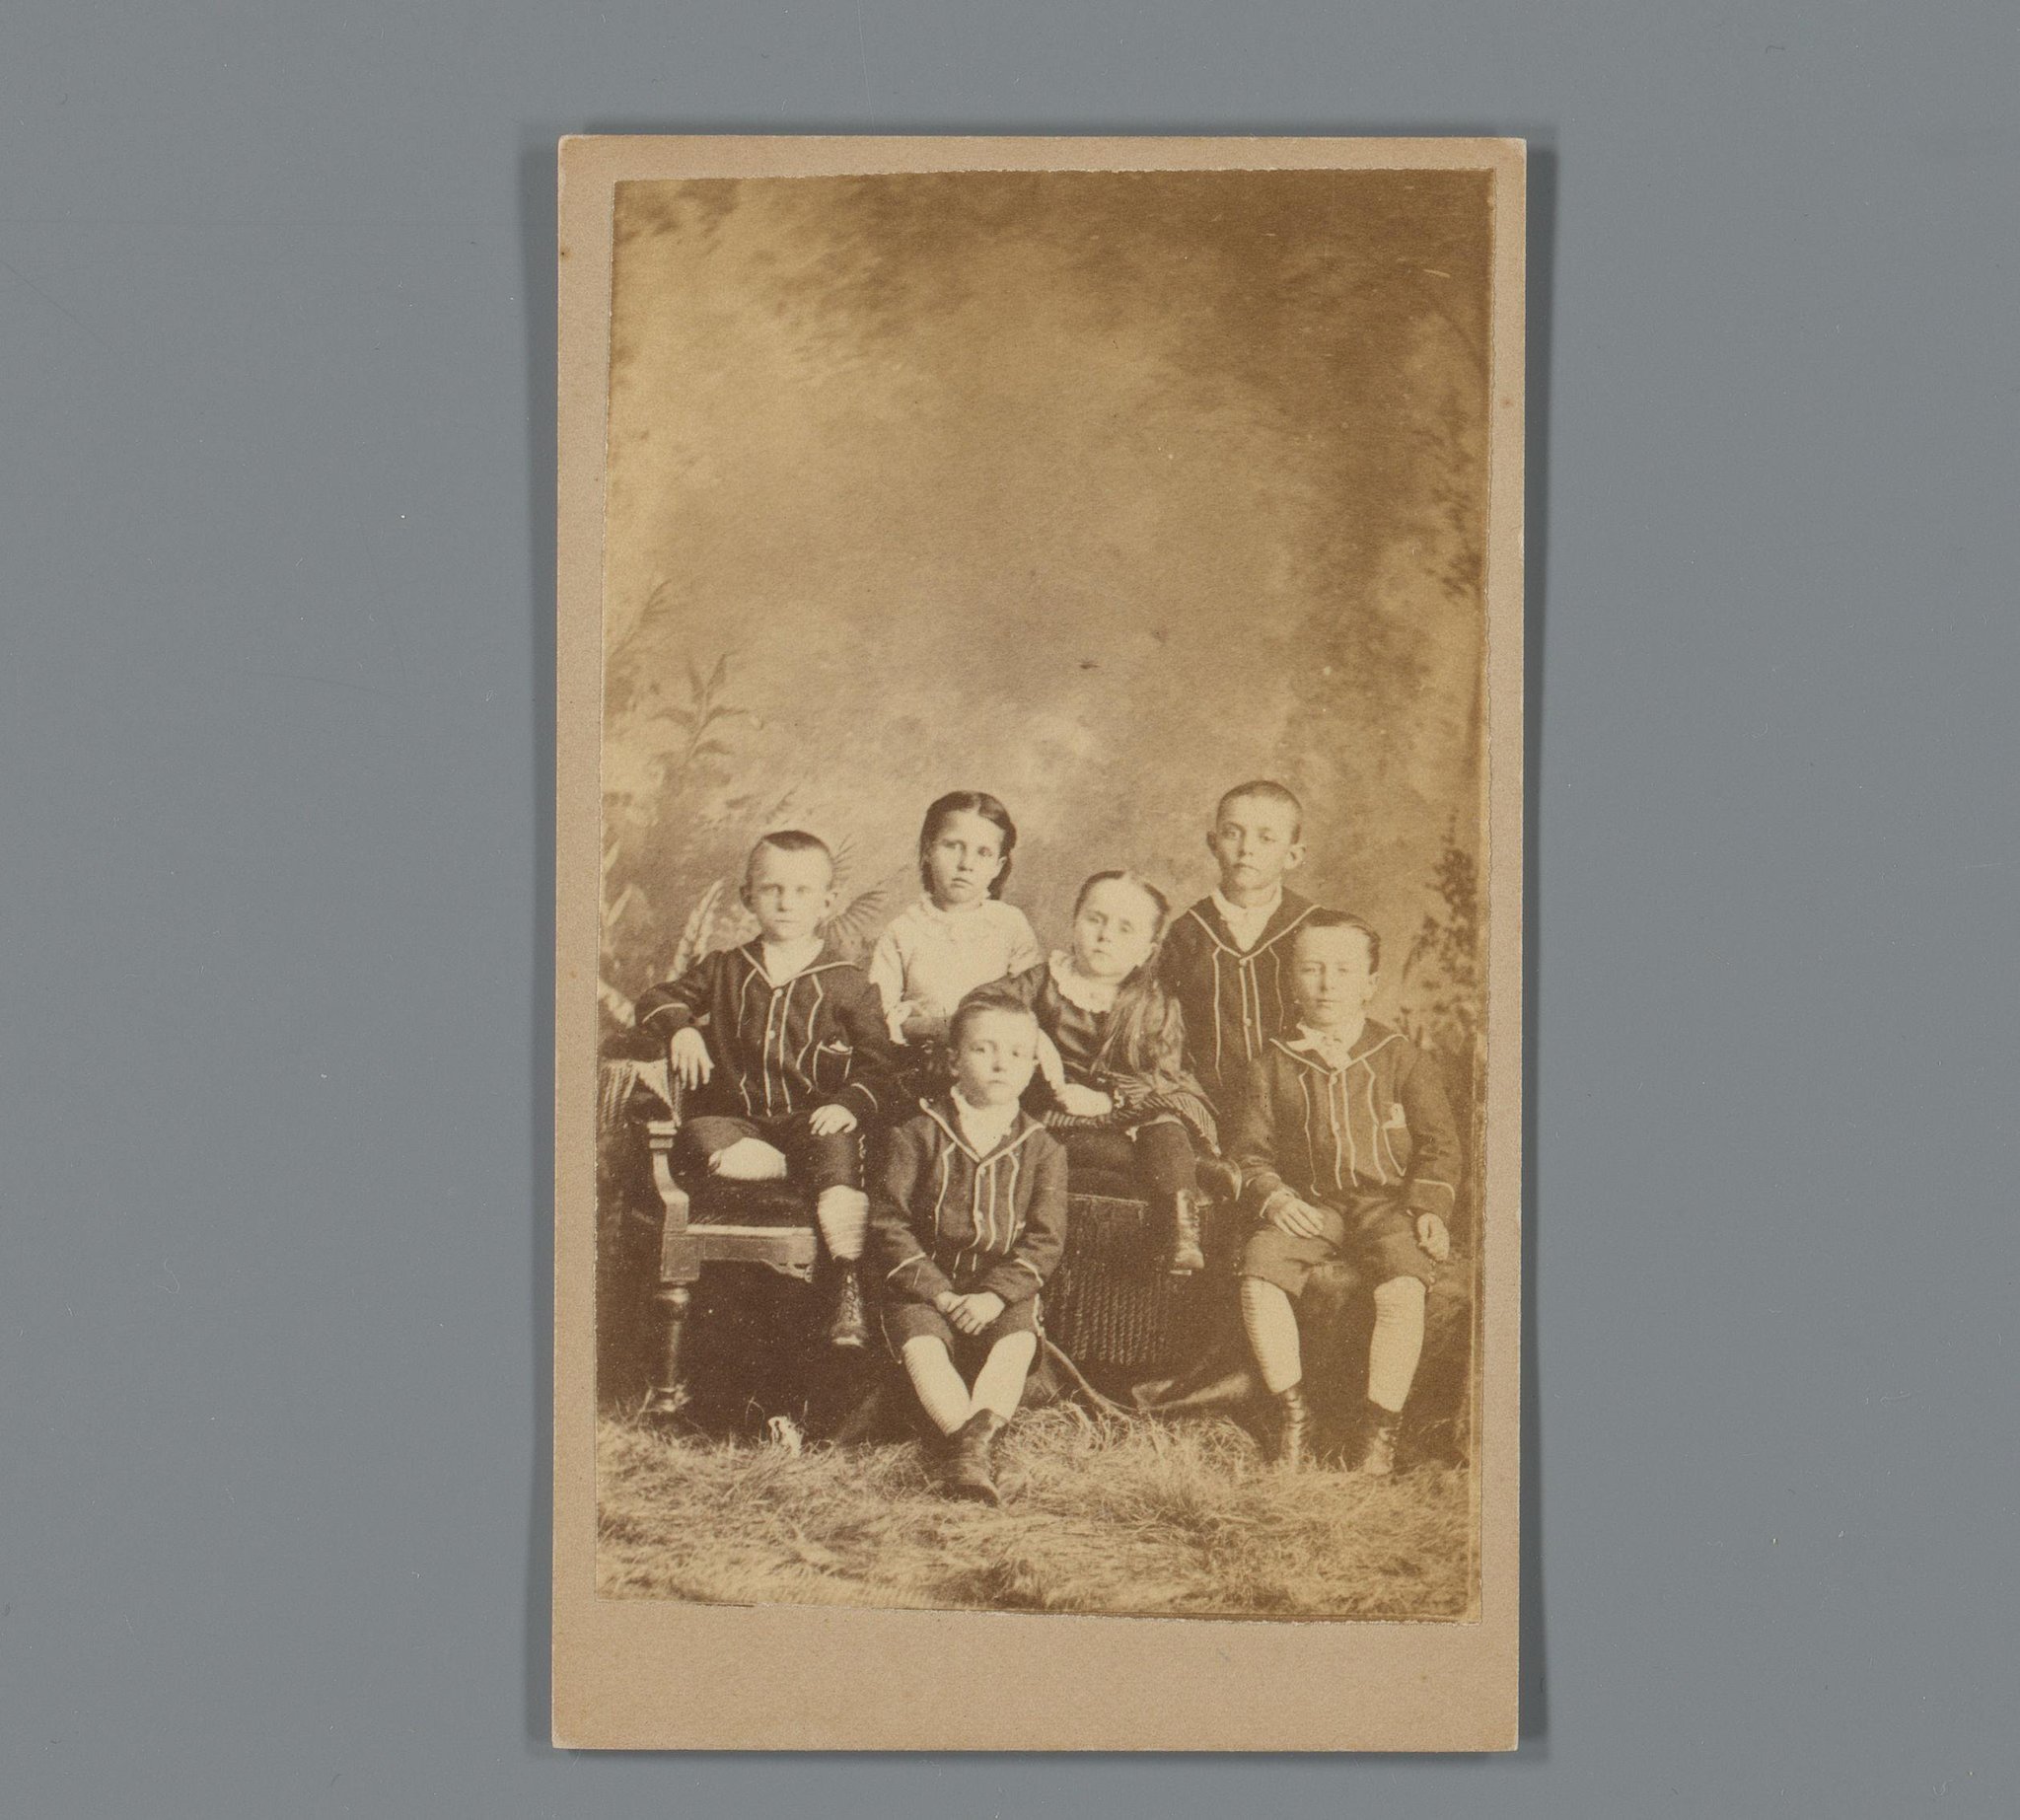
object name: carte de visite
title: True sympathy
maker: Anonymous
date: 1850-1915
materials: cardboard, photographic support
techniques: albumen print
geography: ohio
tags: orphans, anonymous historical persons portrayed in a group, in a group-portrait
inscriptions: inscription: ‘(...)/ G.W. McWHERTER,/ Superintendant.’